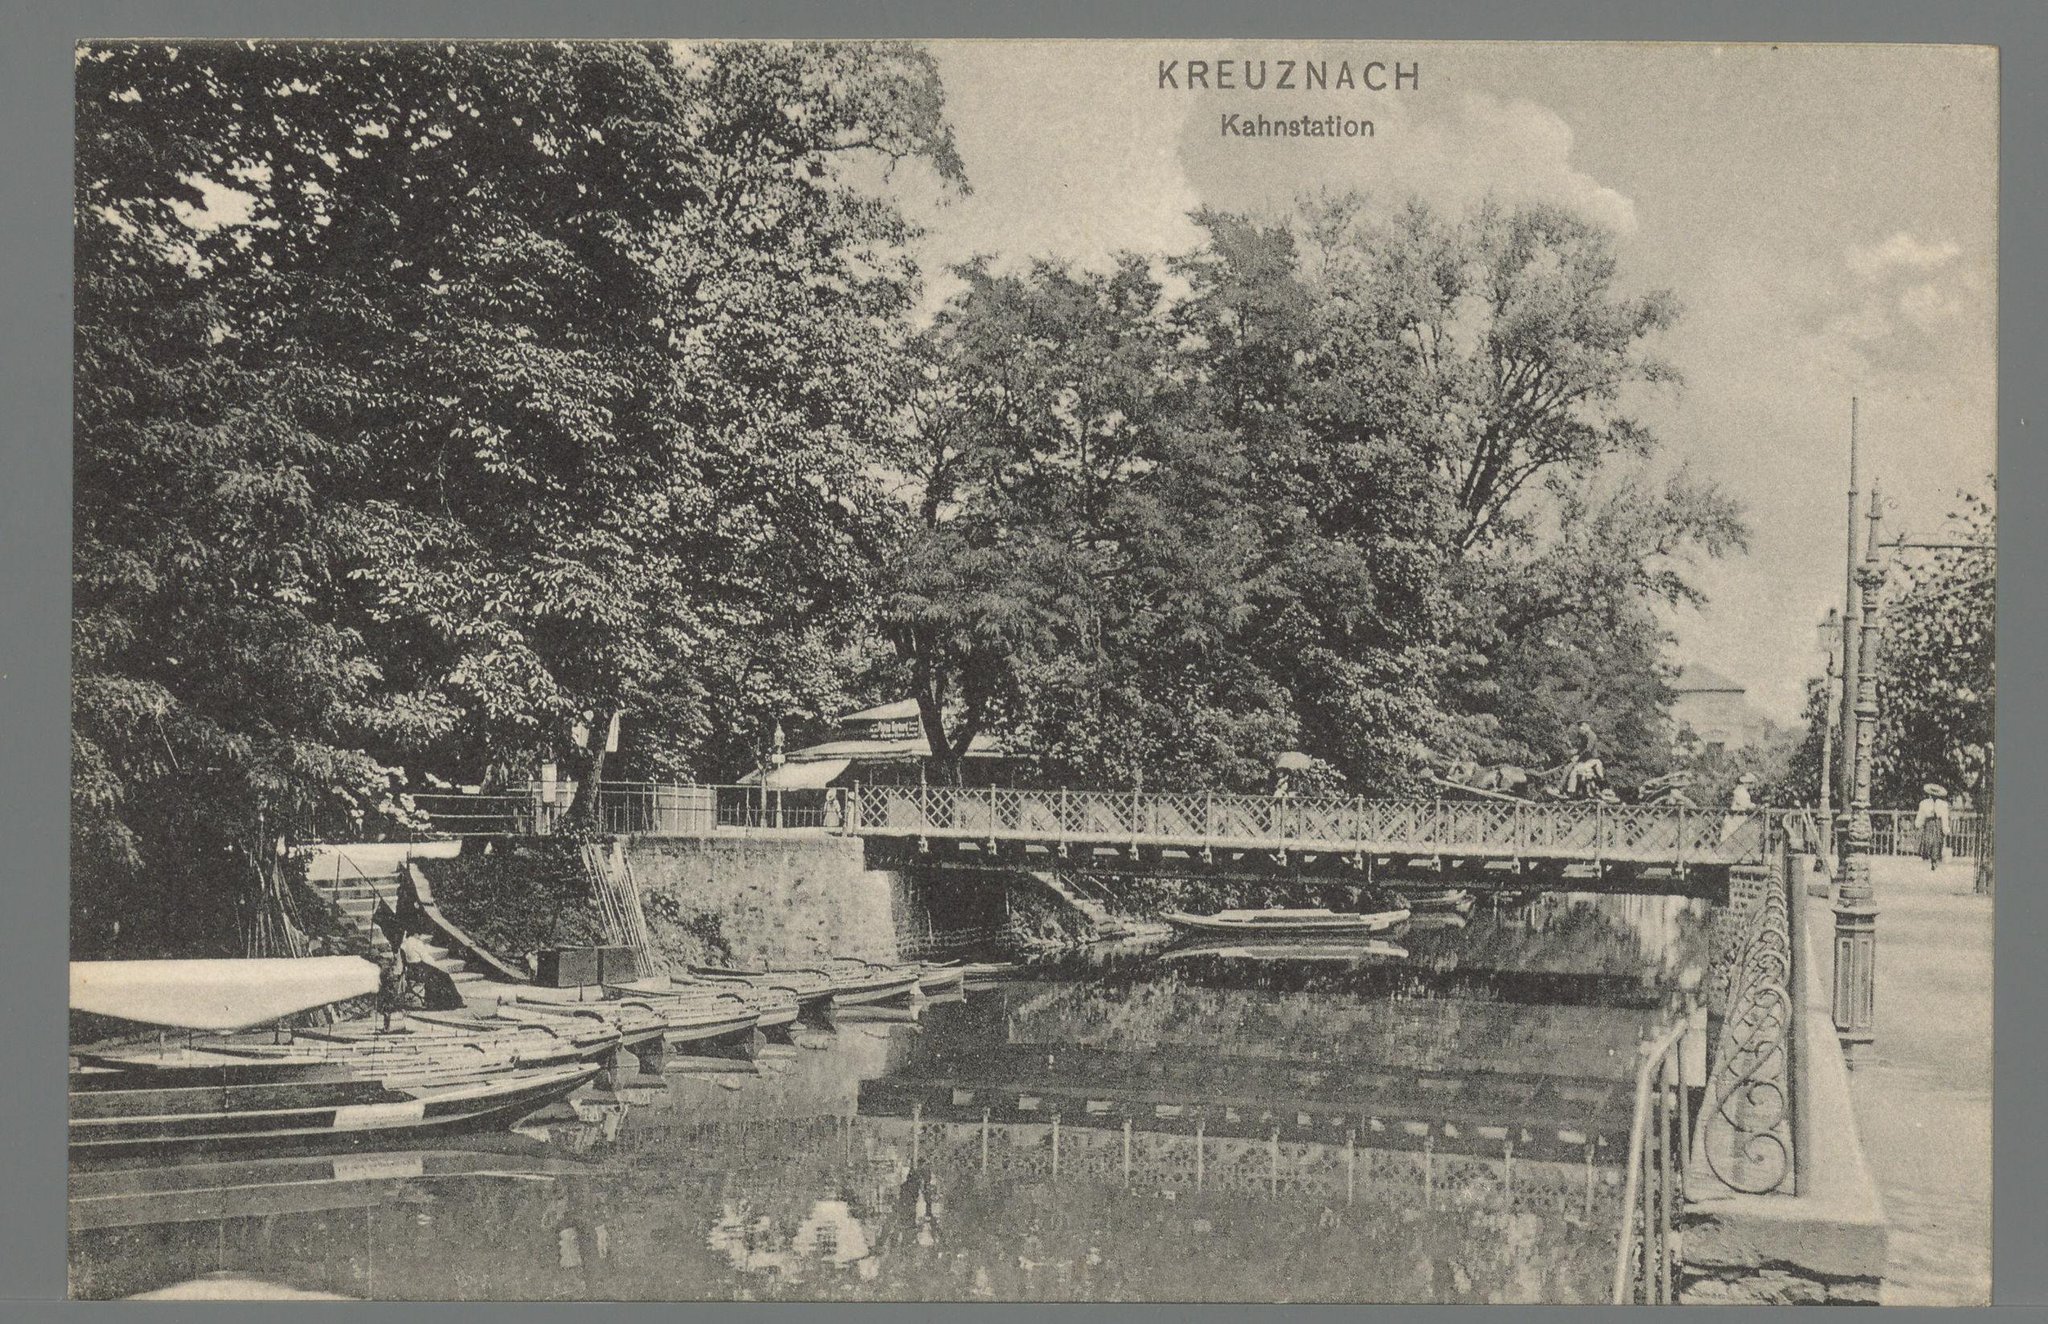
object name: ansichtkaart, prentbriefkaart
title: Kreuznach. Kahnstation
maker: Anonymous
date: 1907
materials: cardboard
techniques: photograph, writing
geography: bad kreuznach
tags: canals, waters (in city), bridge in city across river, canal, etc.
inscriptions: date